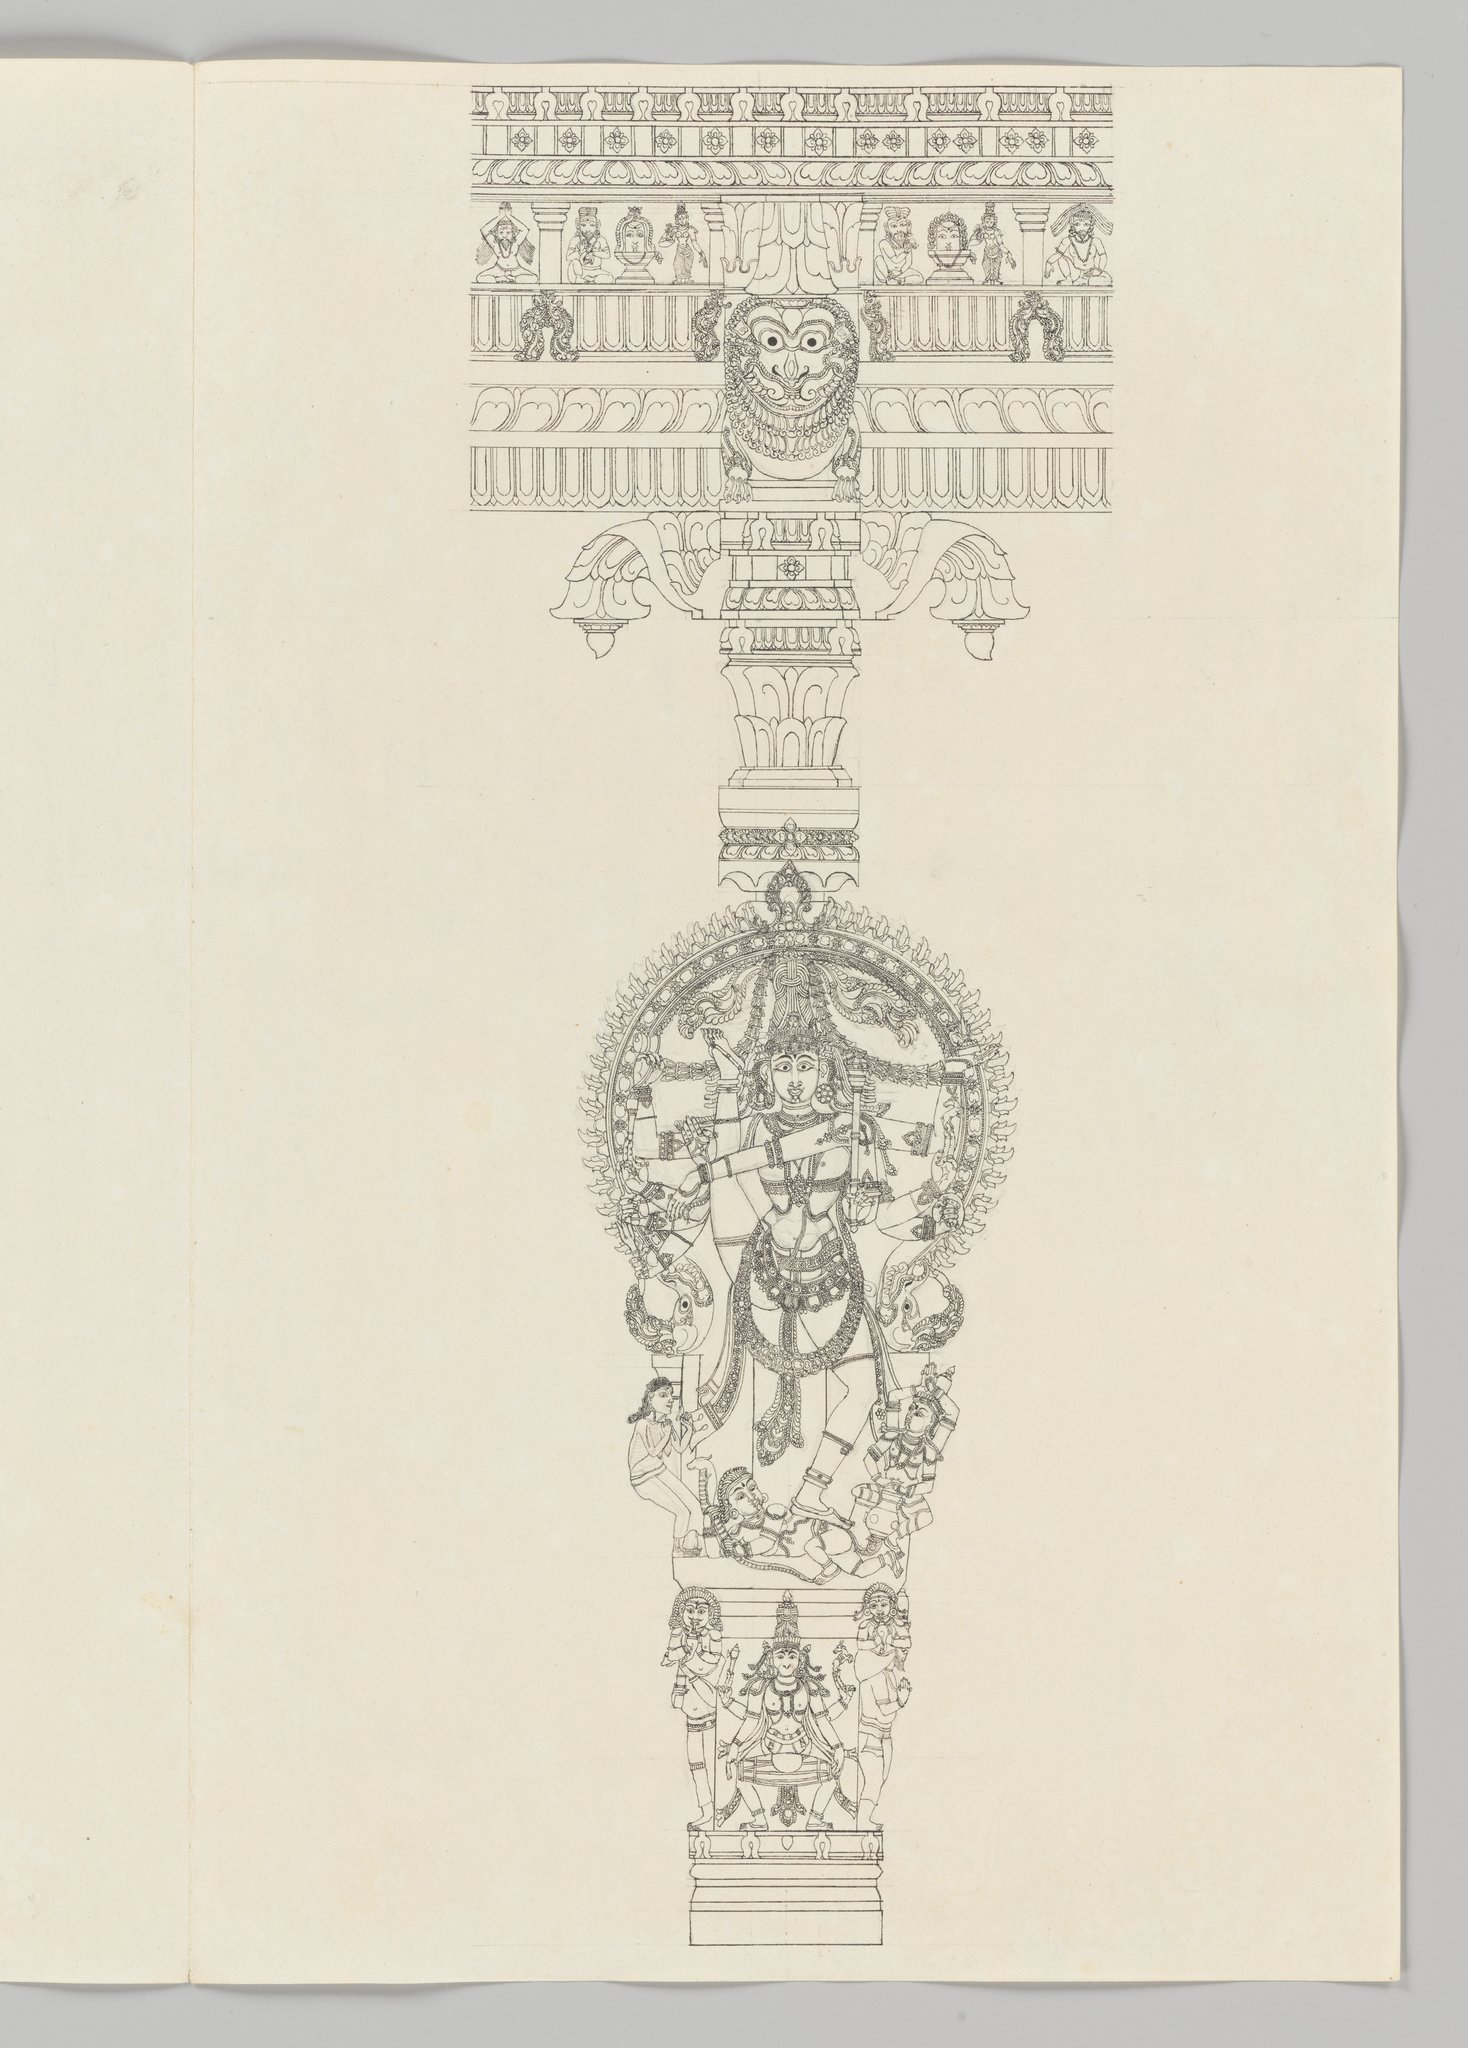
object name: drawing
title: Shiva Urdhvatandava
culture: indian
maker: unidentified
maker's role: artist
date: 1800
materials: ink, paper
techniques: wash